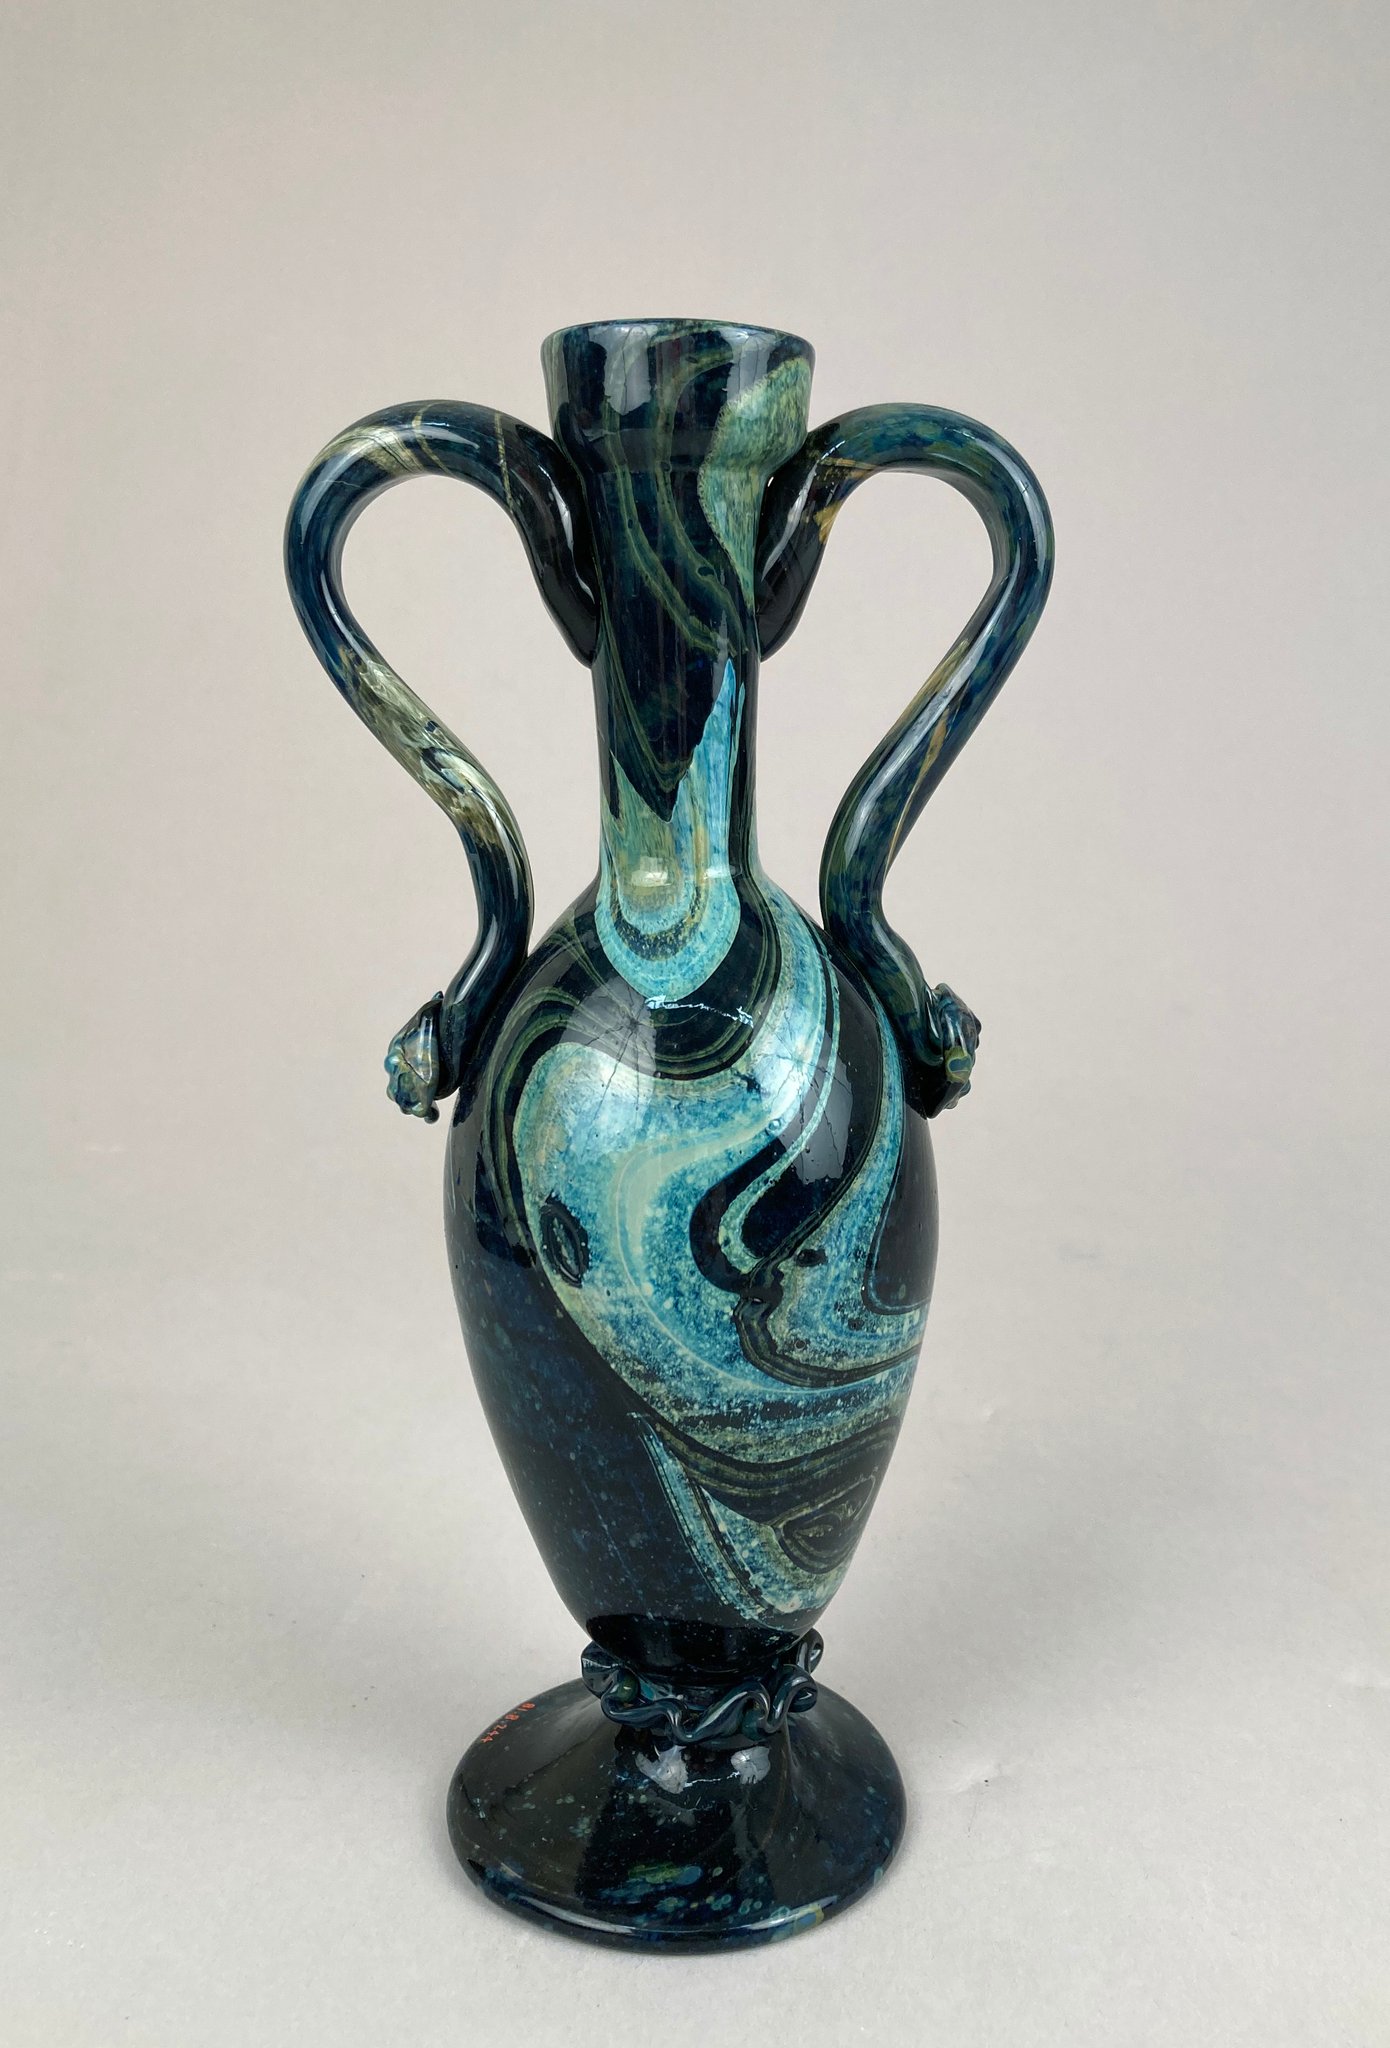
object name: vase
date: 1801-1900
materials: glass